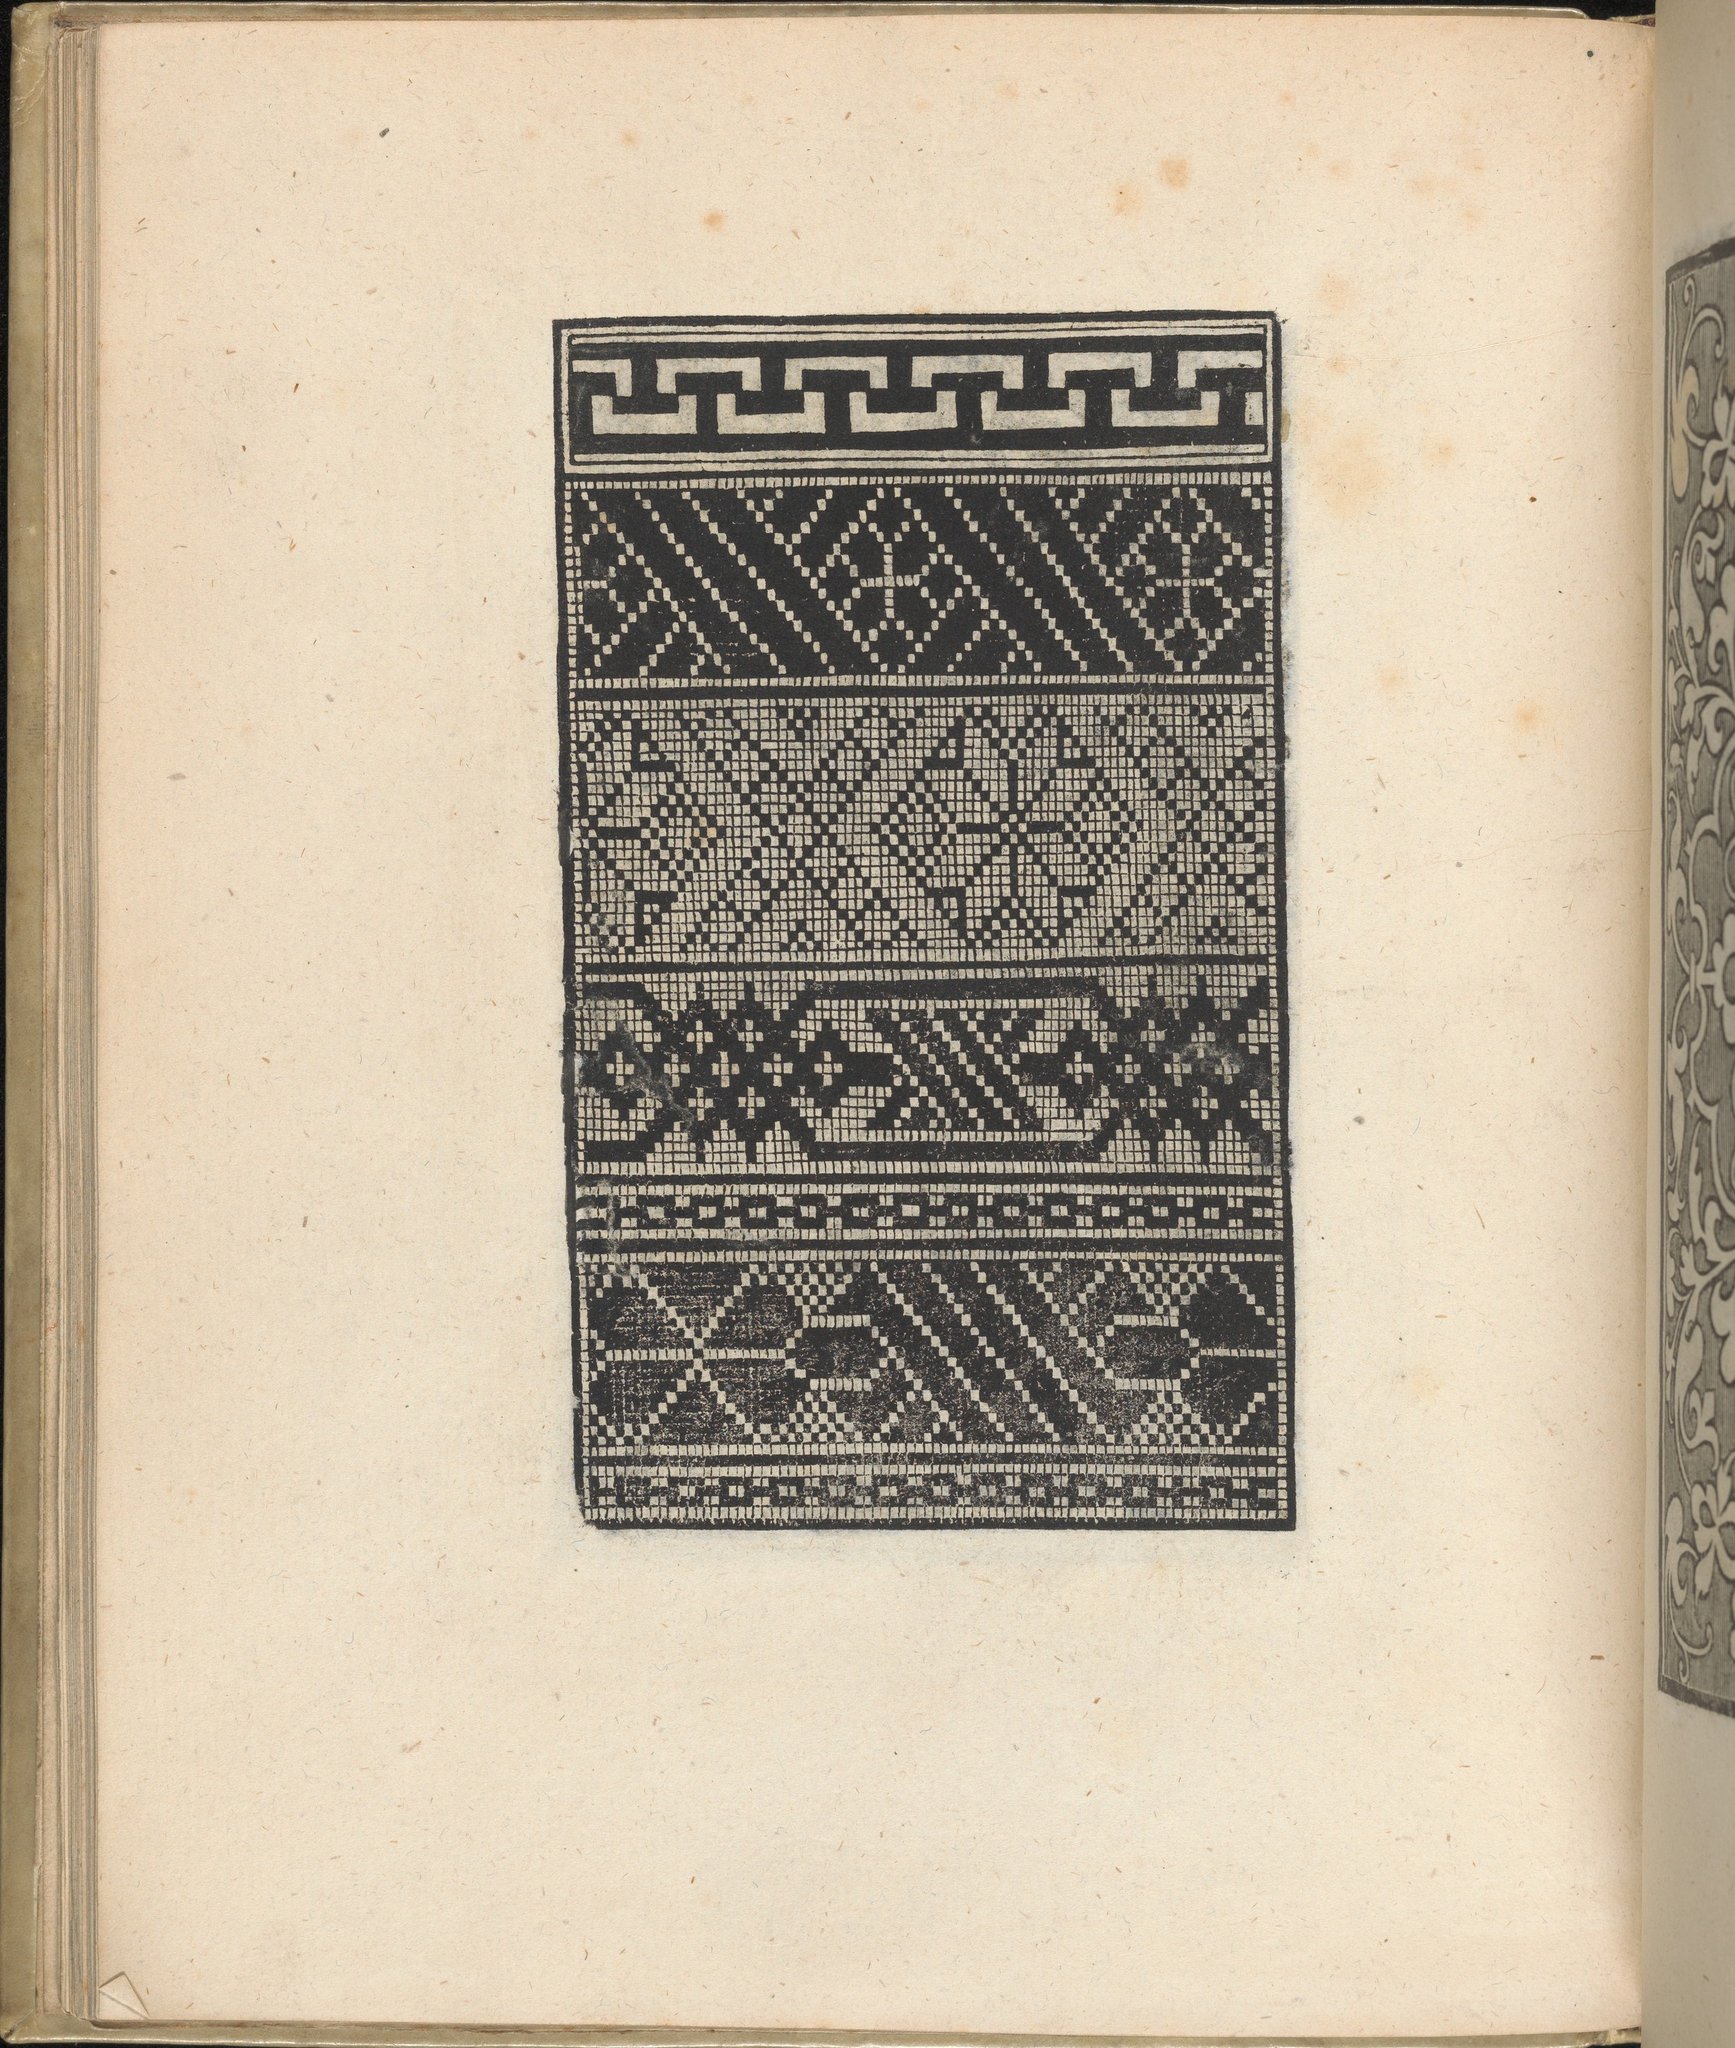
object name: book print ornament architecture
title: Trionfo Di Virtu. Libro Novo..., page 26 (recto)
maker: matteo pagano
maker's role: publisher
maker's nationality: italian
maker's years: 1515-1588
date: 1563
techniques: woodcut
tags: ornament